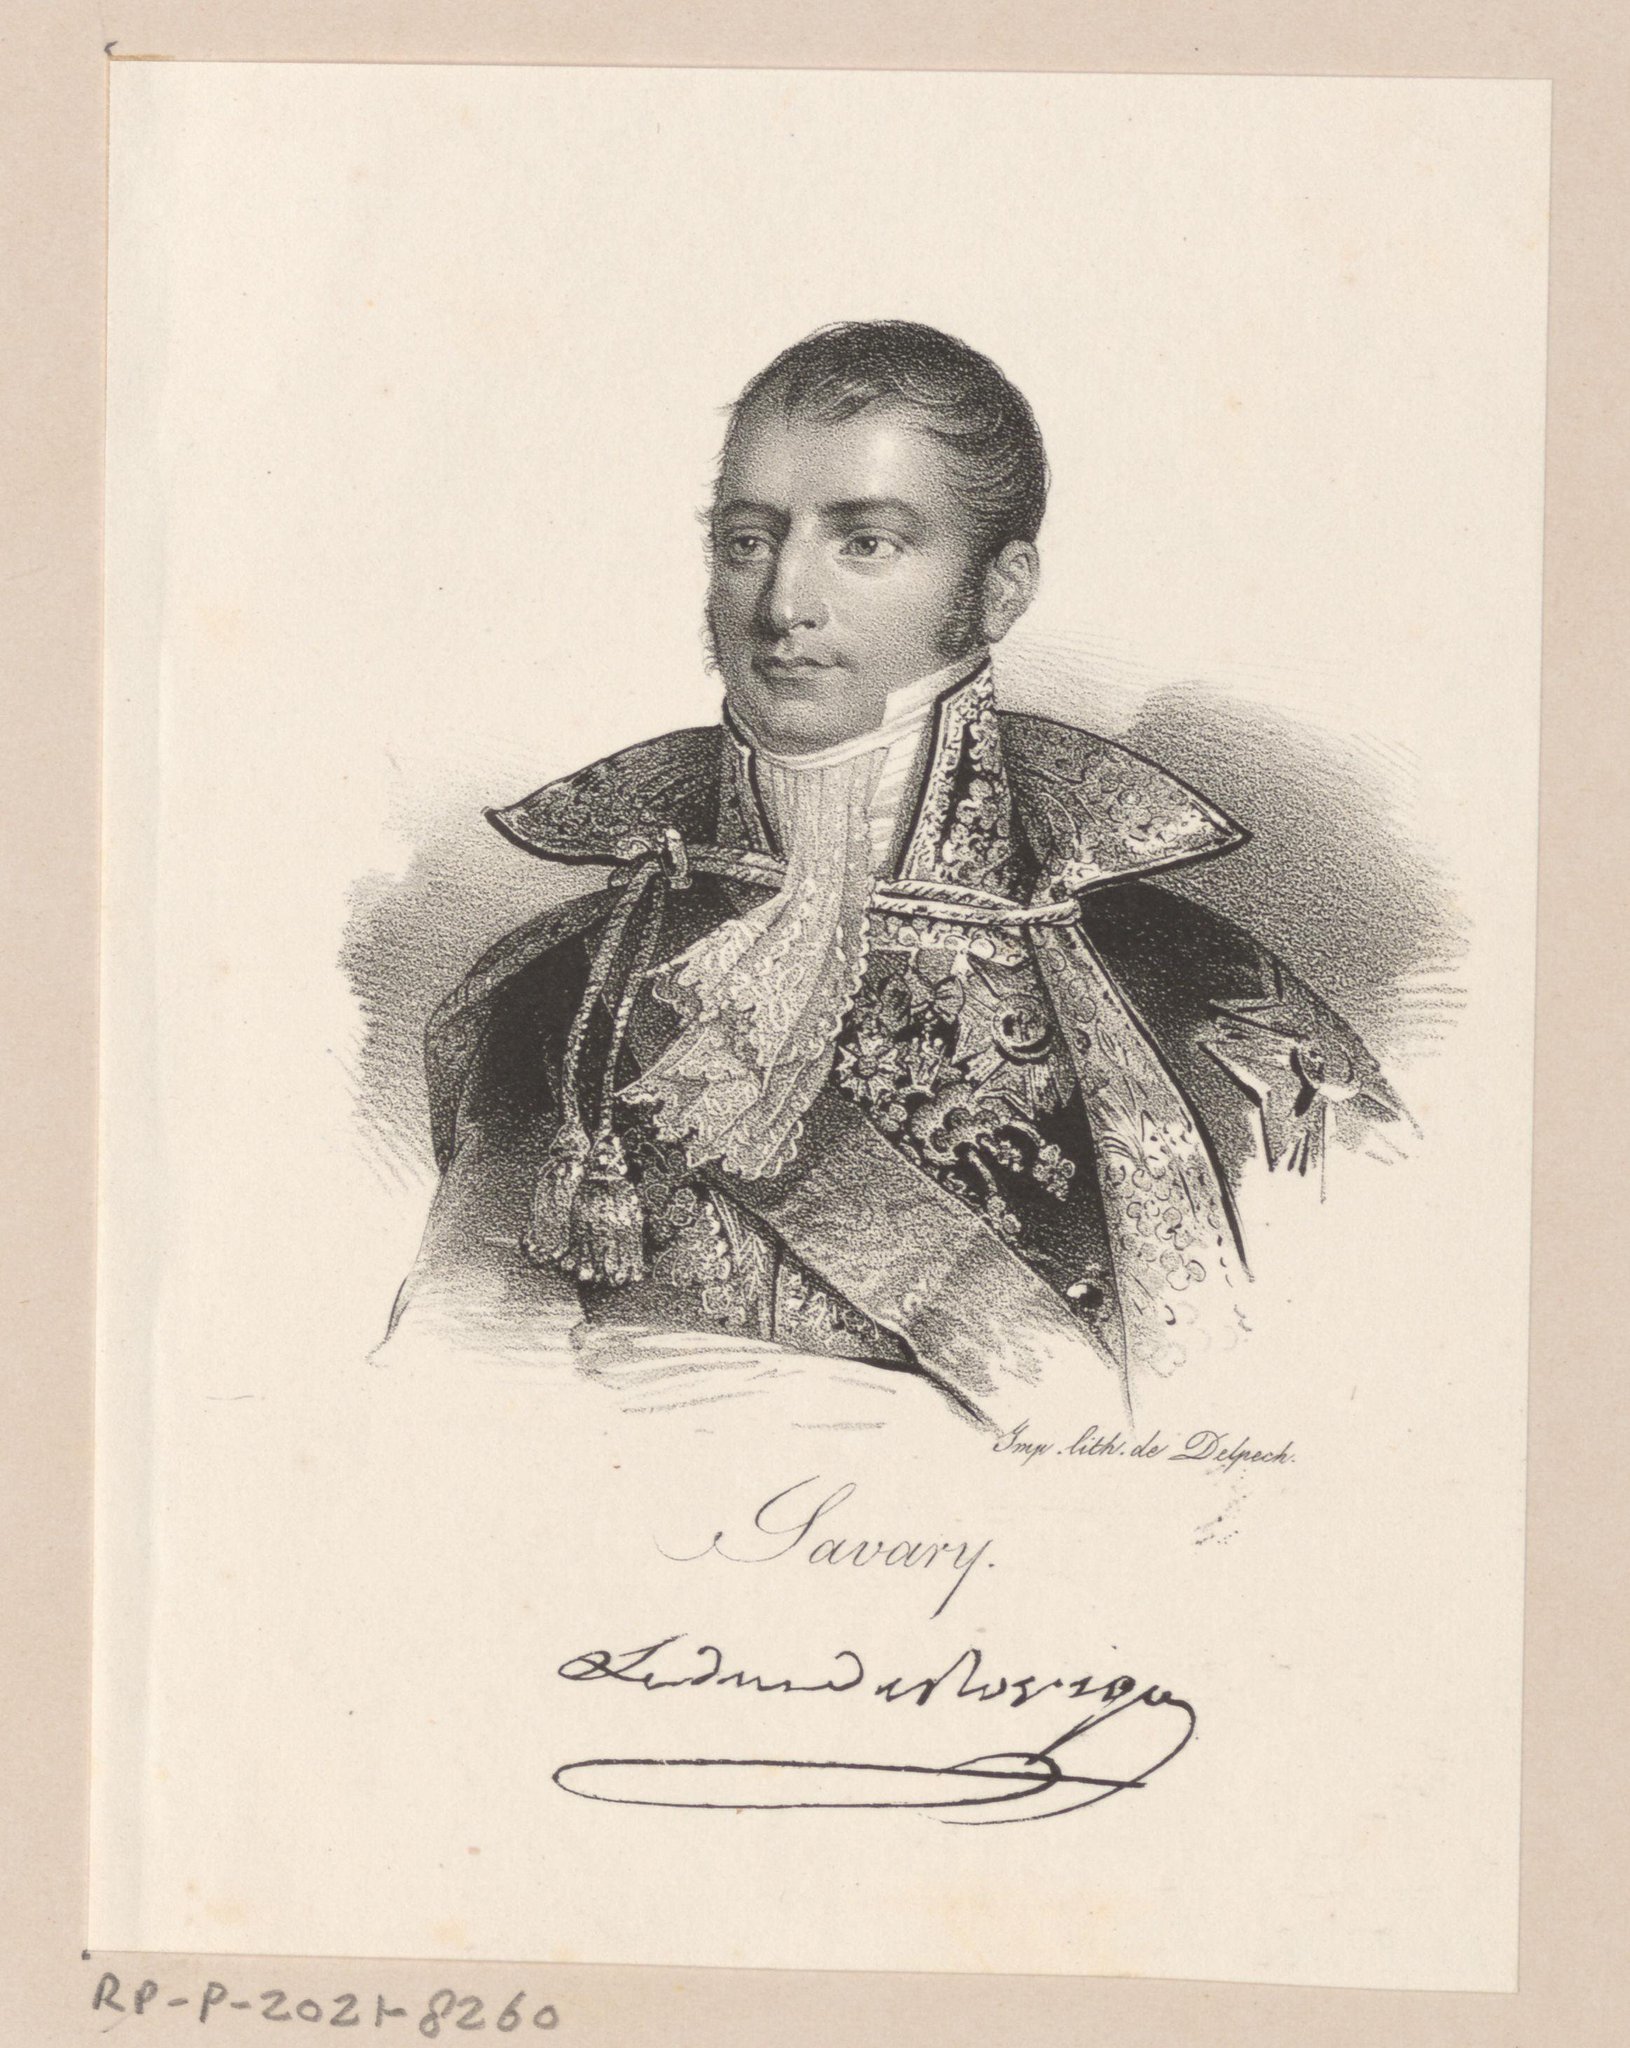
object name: print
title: Portret van Anne Jean Marie René Savary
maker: Anonymous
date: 1818-1842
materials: paper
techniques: lithograph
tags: paris, commander-in-chief, general, marshal, historical persons